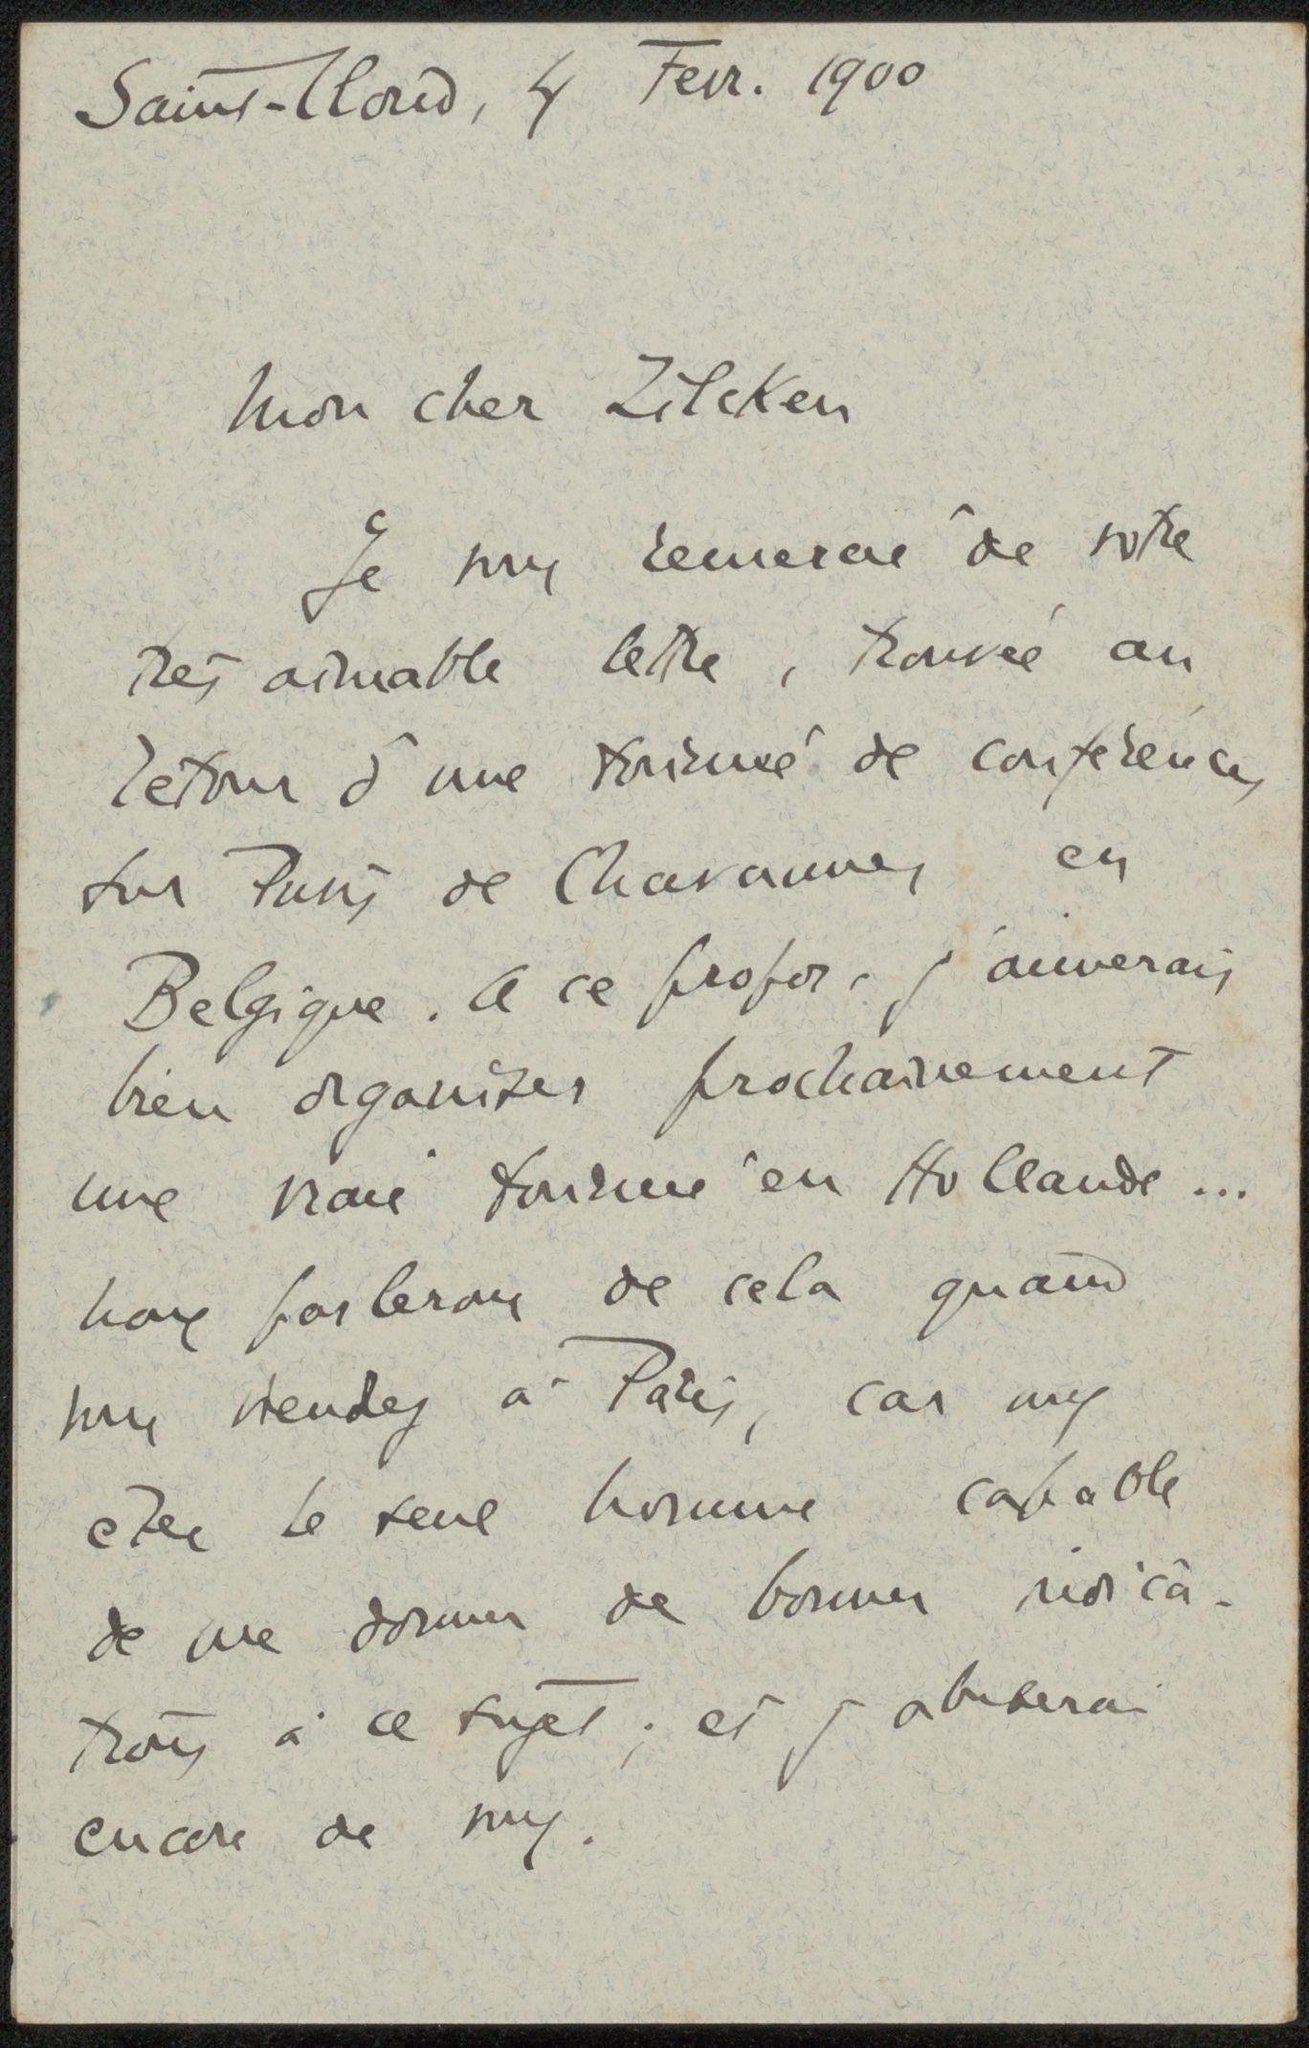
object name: letter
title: Brief aan Philip Zilcken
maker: gabriel mourey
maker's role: criticus, schrijver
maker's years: 1865-1943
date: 1900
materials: ink, paper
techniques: pen, writing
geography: saint-cloud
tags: painter, print maker, draughtsman, johan barthold jongkind, lyon, paris, pierre cécile puvis de chavannes, publisher, the hague, philip zilcken, belgium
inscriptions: collector's mark: ‘RPK’